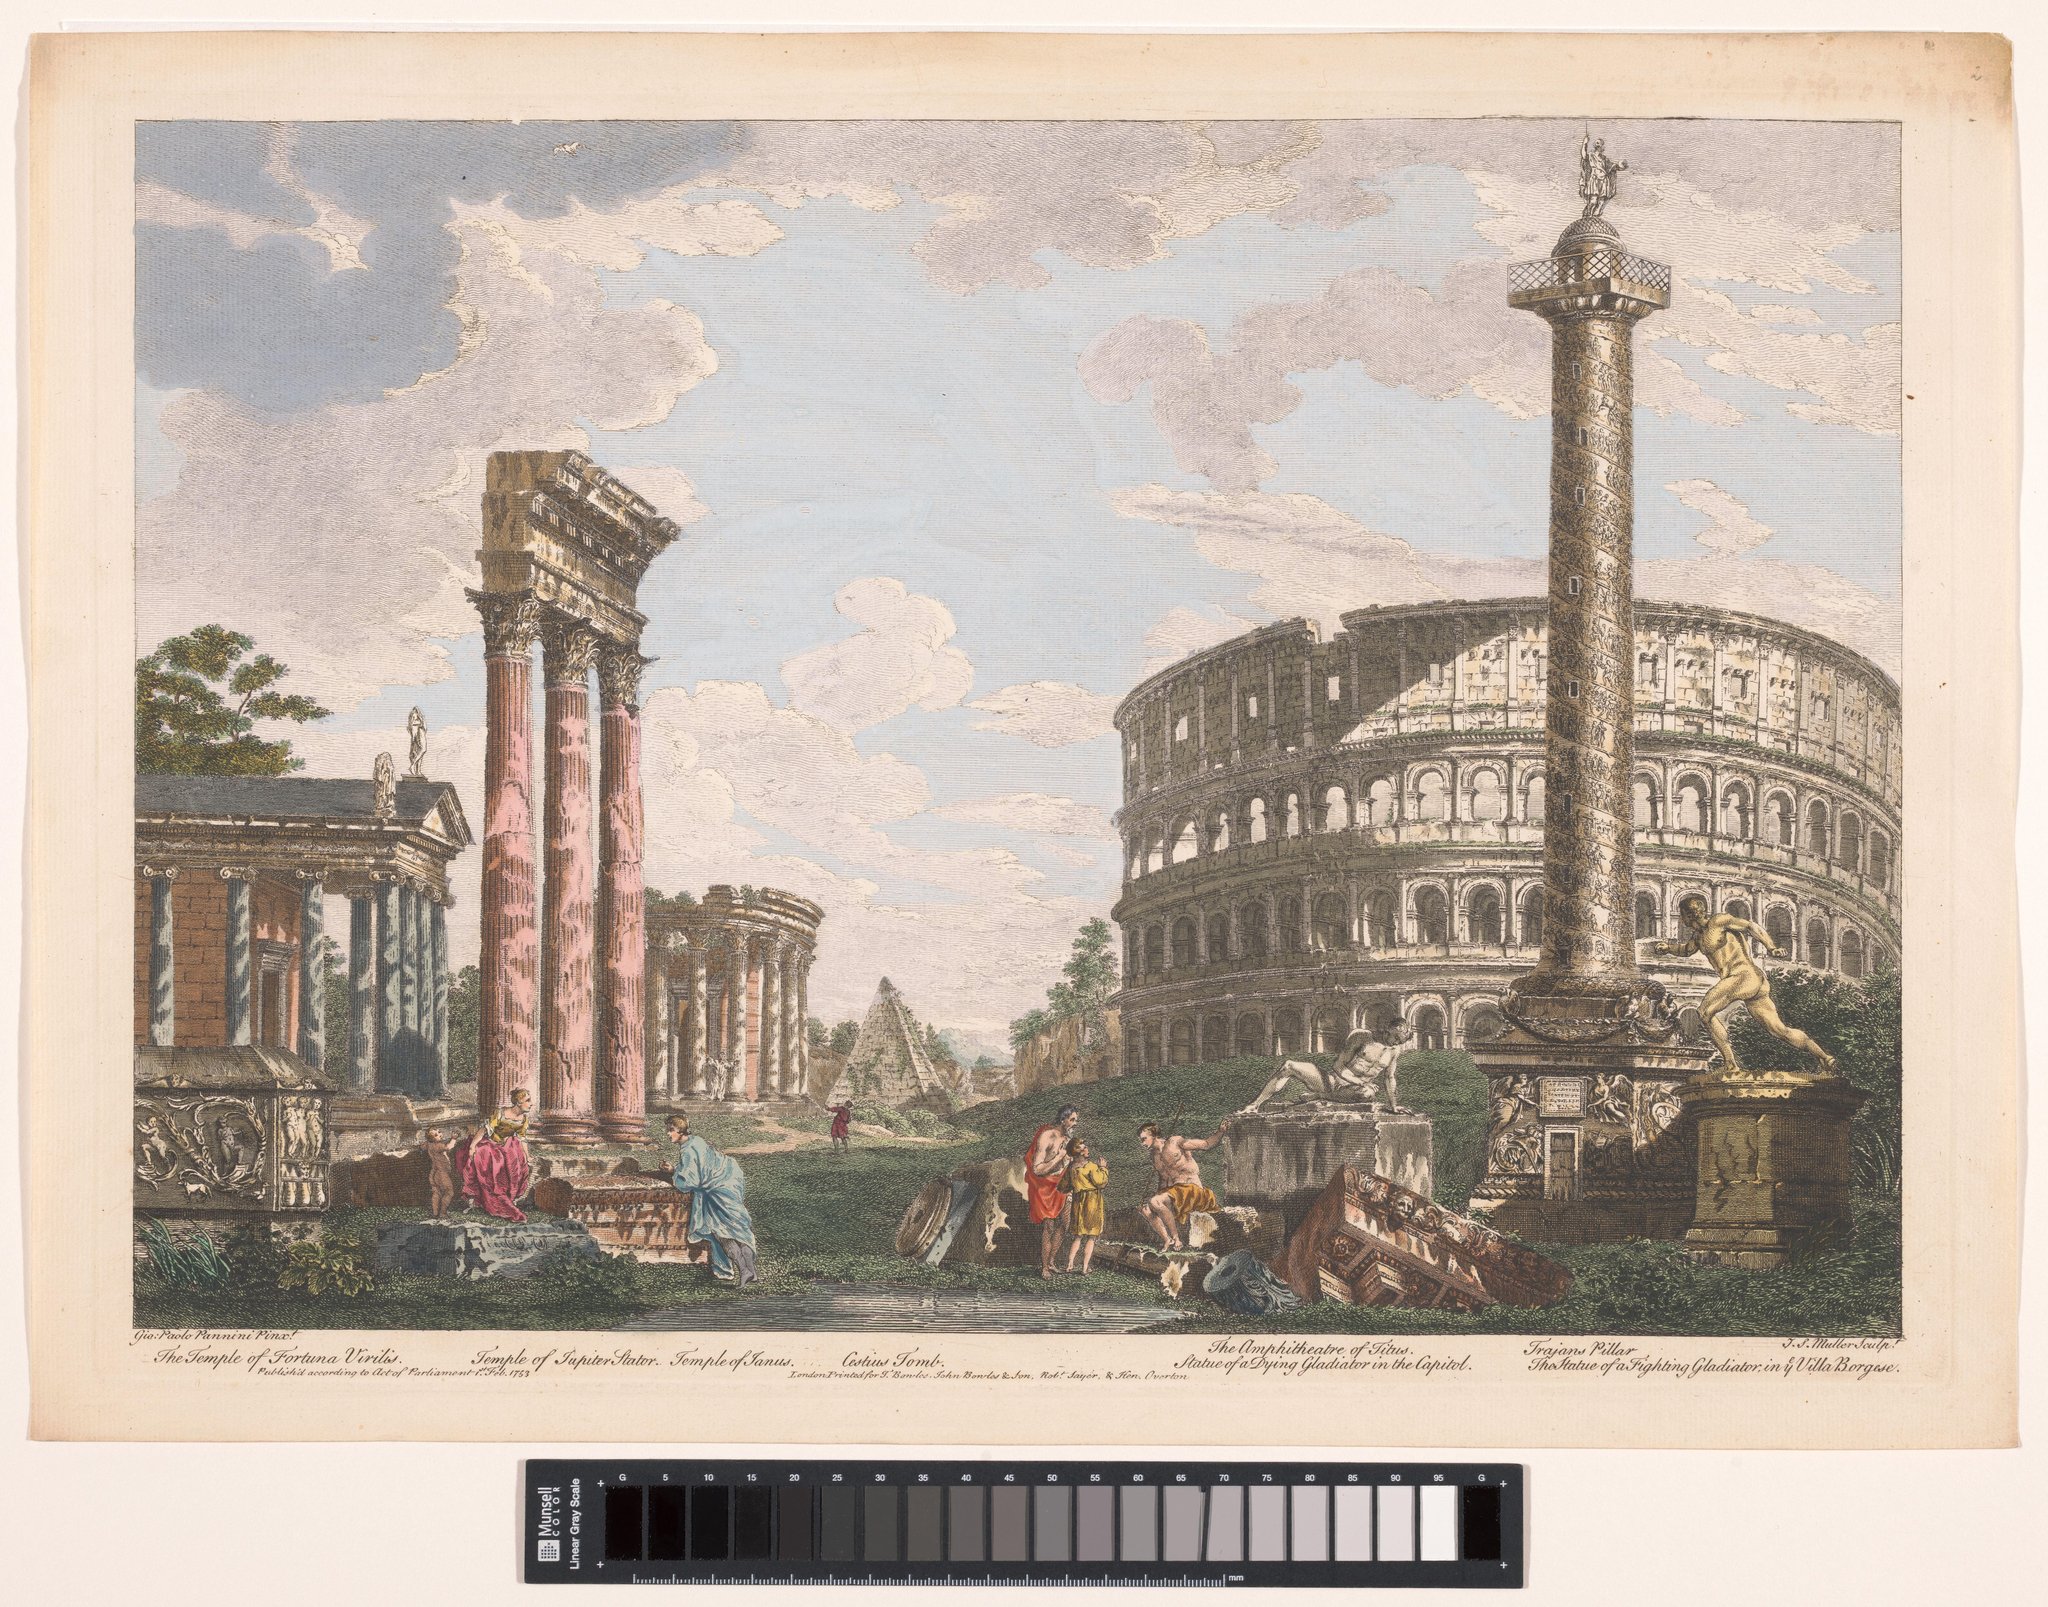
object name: opticaprent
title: Romeinse oudheid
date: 1753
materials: paper, watercolor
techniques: brush, etching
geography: london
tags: column (marking grave), mausoleum, theatre (building), temple, shrine ~ roman religion, sculpture, landscape with ruins (+ city(-scape) with figures, staffage)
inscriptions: watermark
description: De serie “Romeinse oudheid” bevat zes prenten met de nummers 1-6, waarvan dit nummer 2 is.